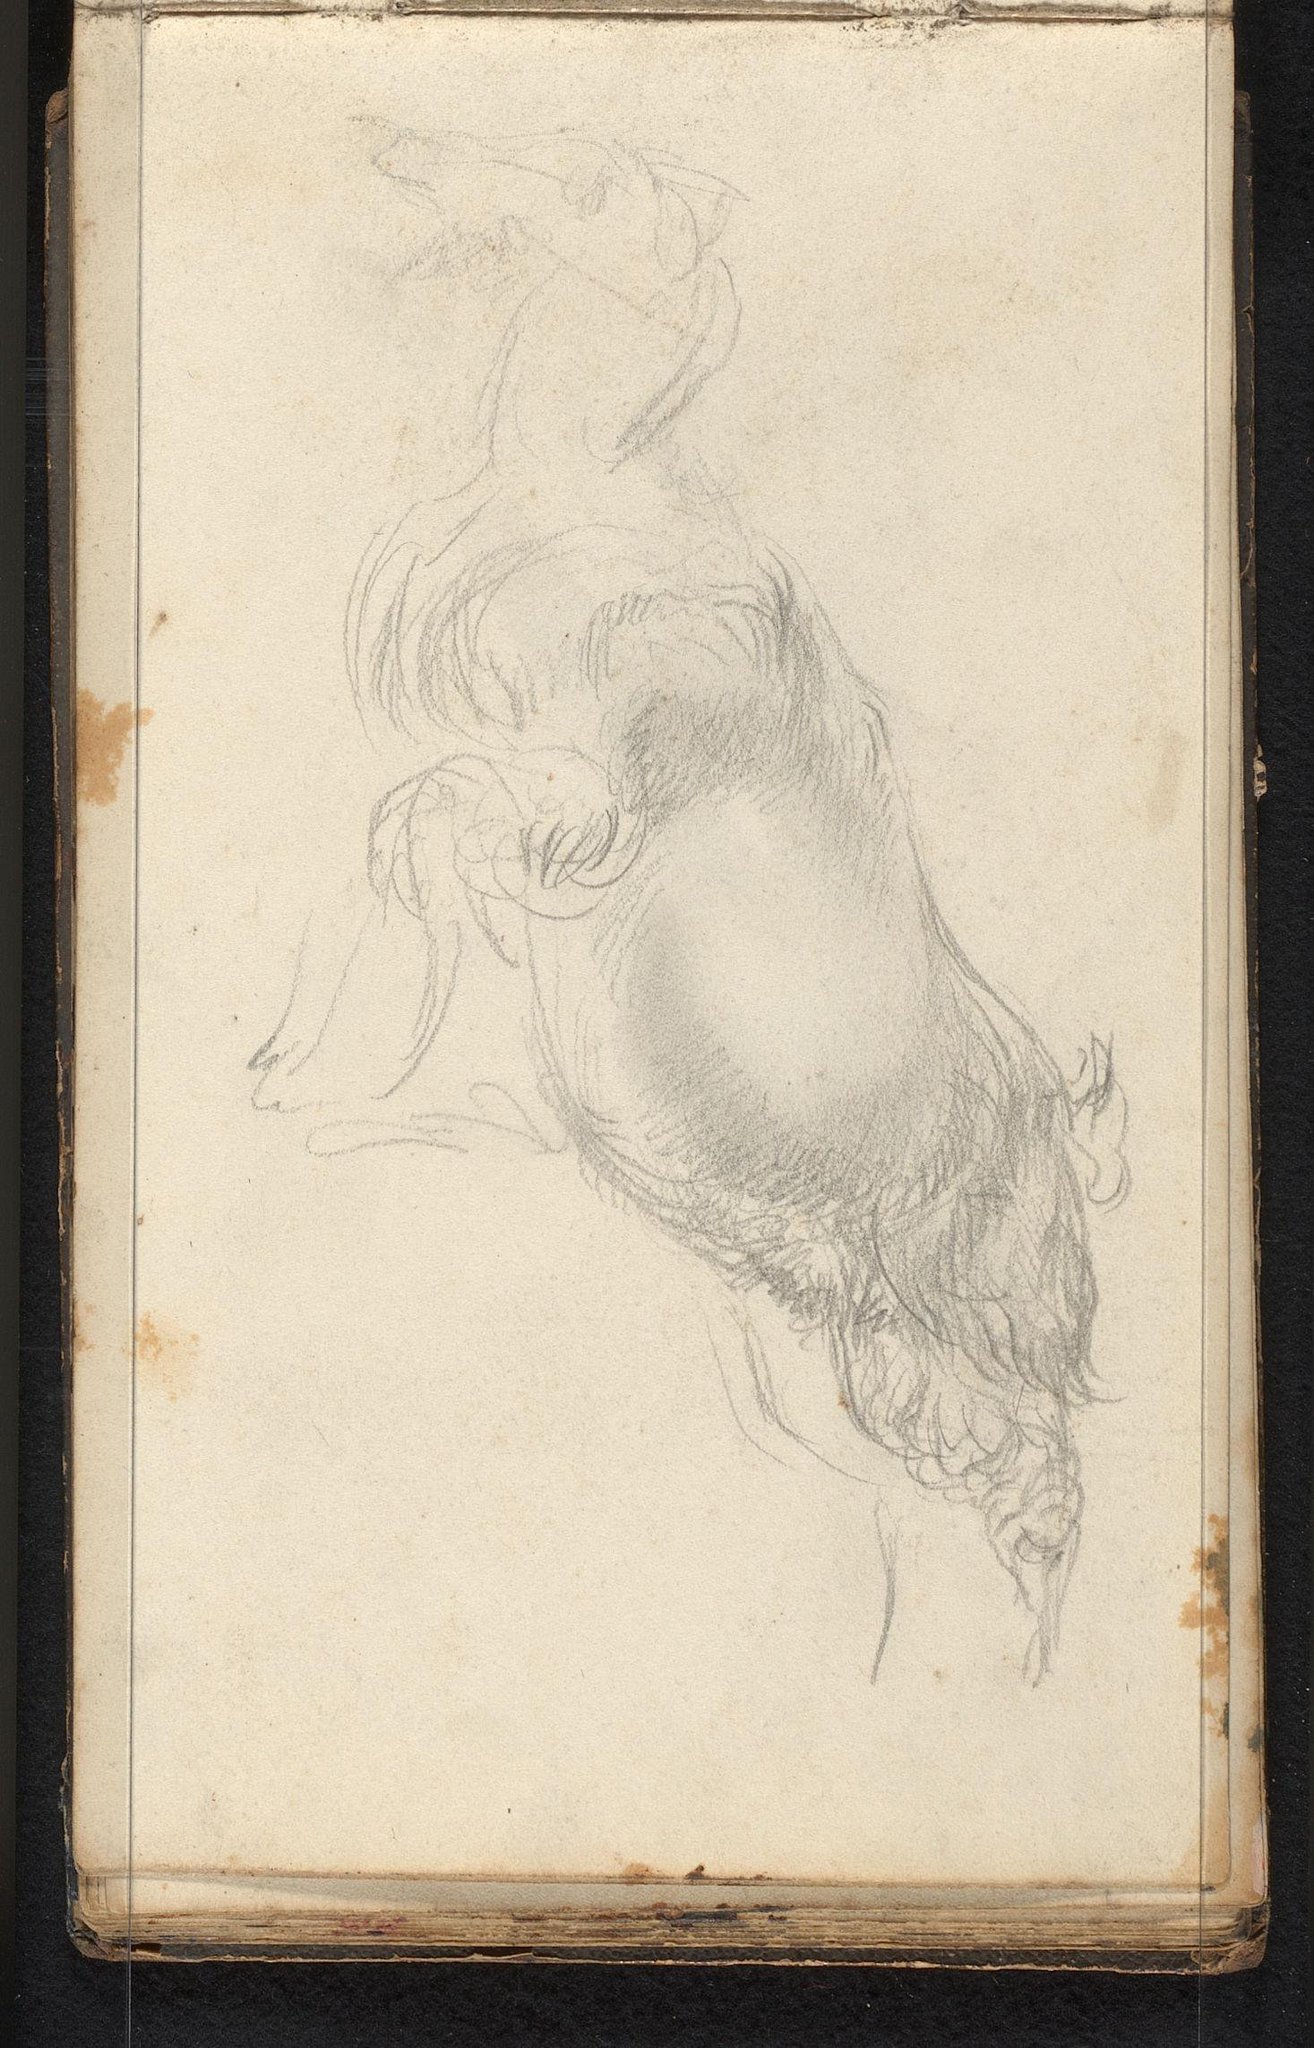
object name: sketchbook leaf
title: Steigerend dier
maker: jan bedijs tom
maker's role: draughtsman, painter, print maker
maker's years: 1813-1894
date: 1828-1894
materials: paper, pencil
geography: the hague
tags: artist (in general) making preliminary designs, sketching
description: Pagina 24 verso uit een schetsboek met 54 bladen.